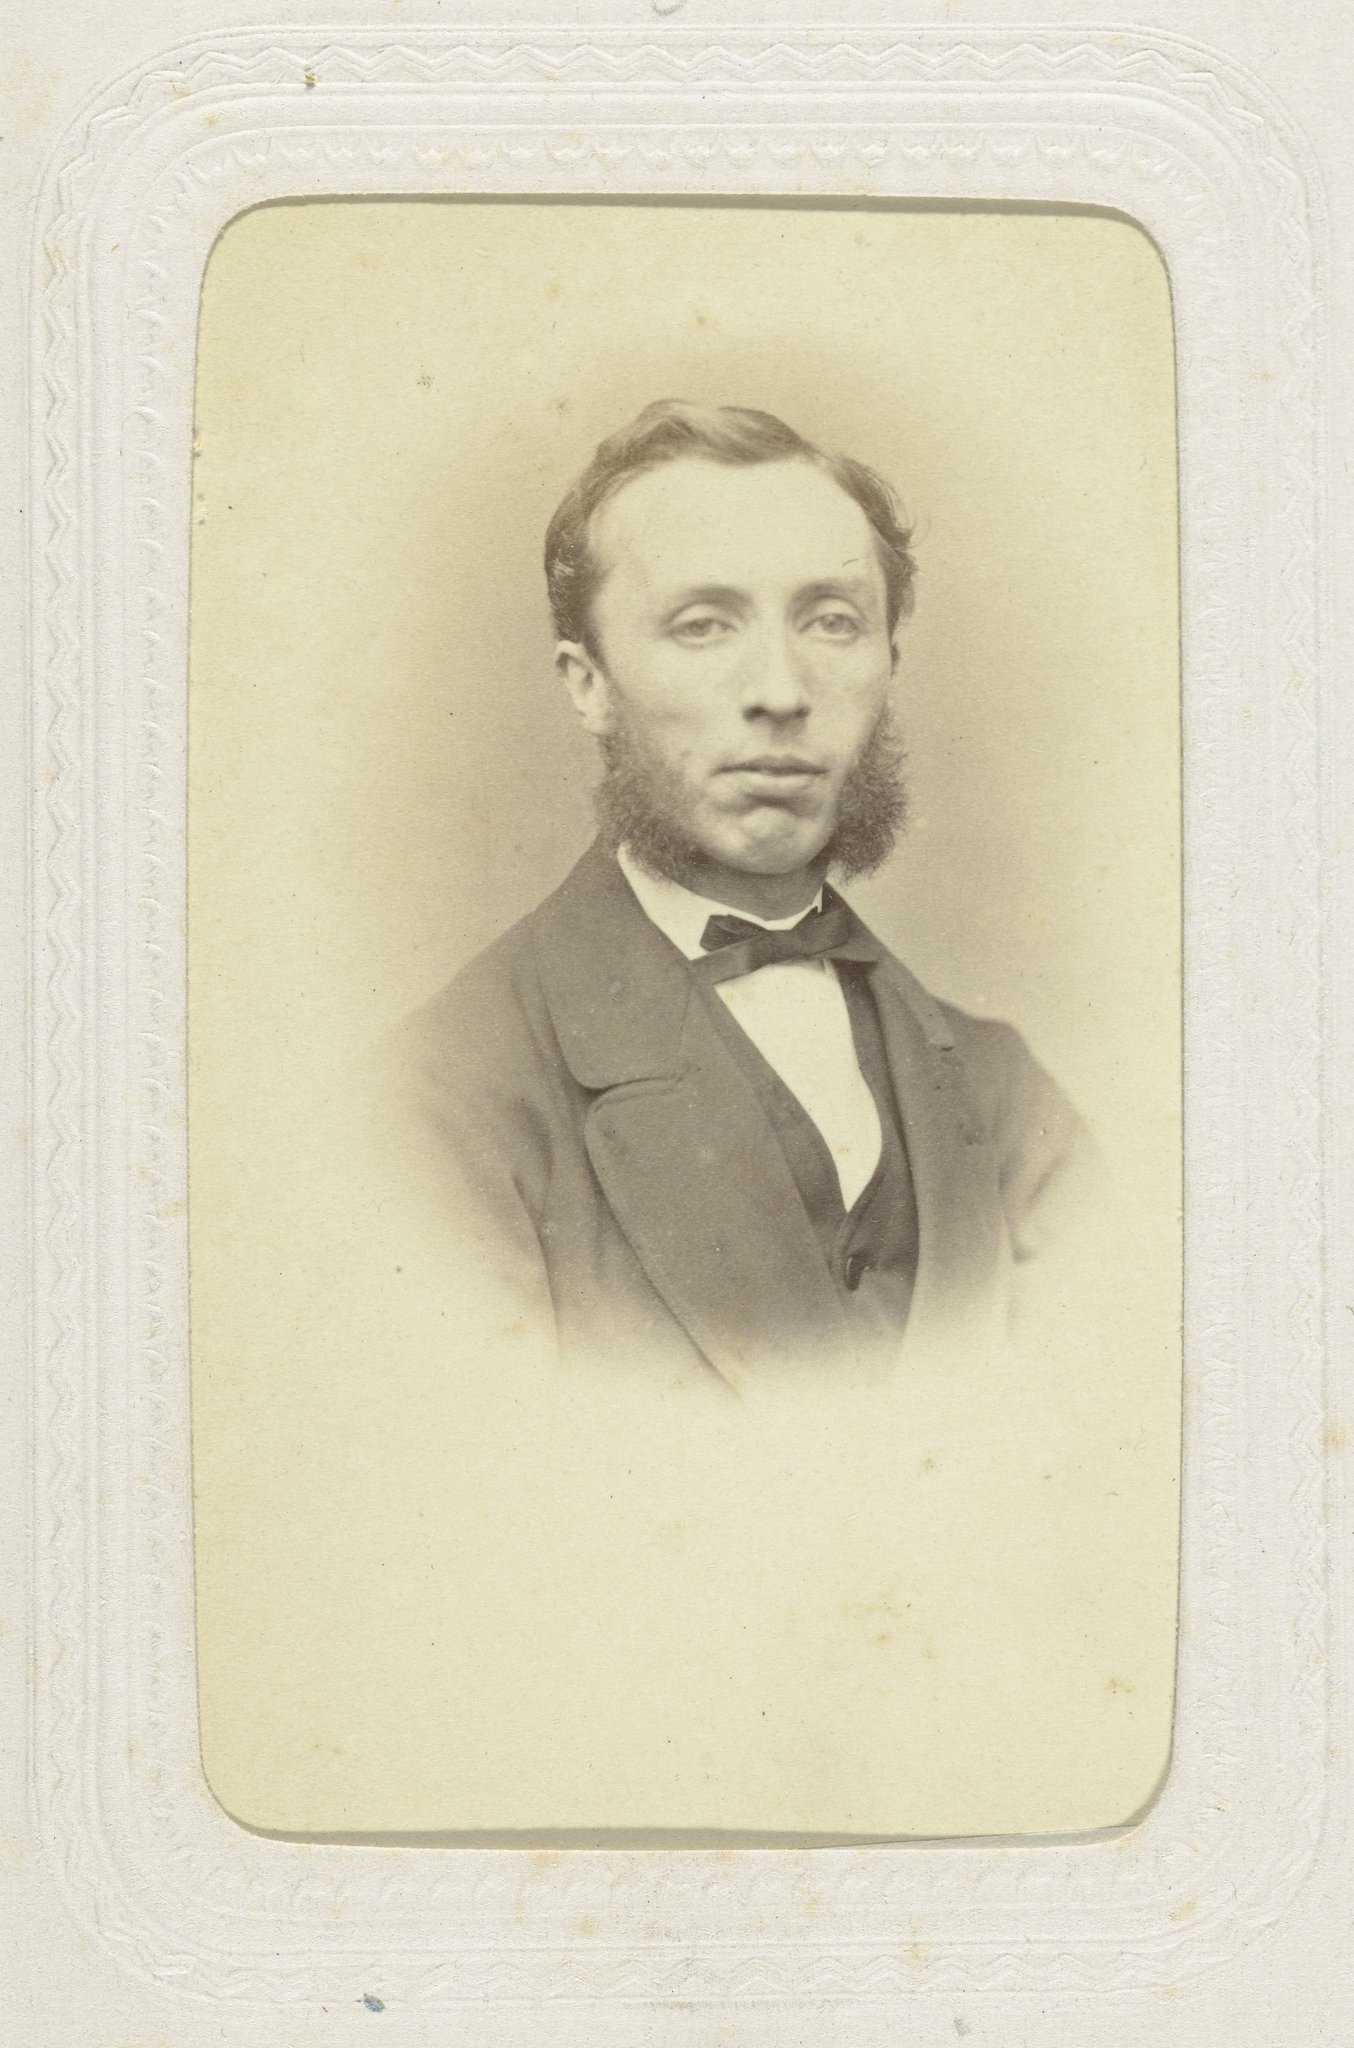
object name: carte de visite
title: Studioportret van een man in kostuum met grote bakkebaarden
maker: albert greiner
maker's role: fotograaf, fotostudio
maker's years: 1833-1890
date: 1863-1870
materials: cardboard, paper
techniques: albumen print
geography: amsterdam